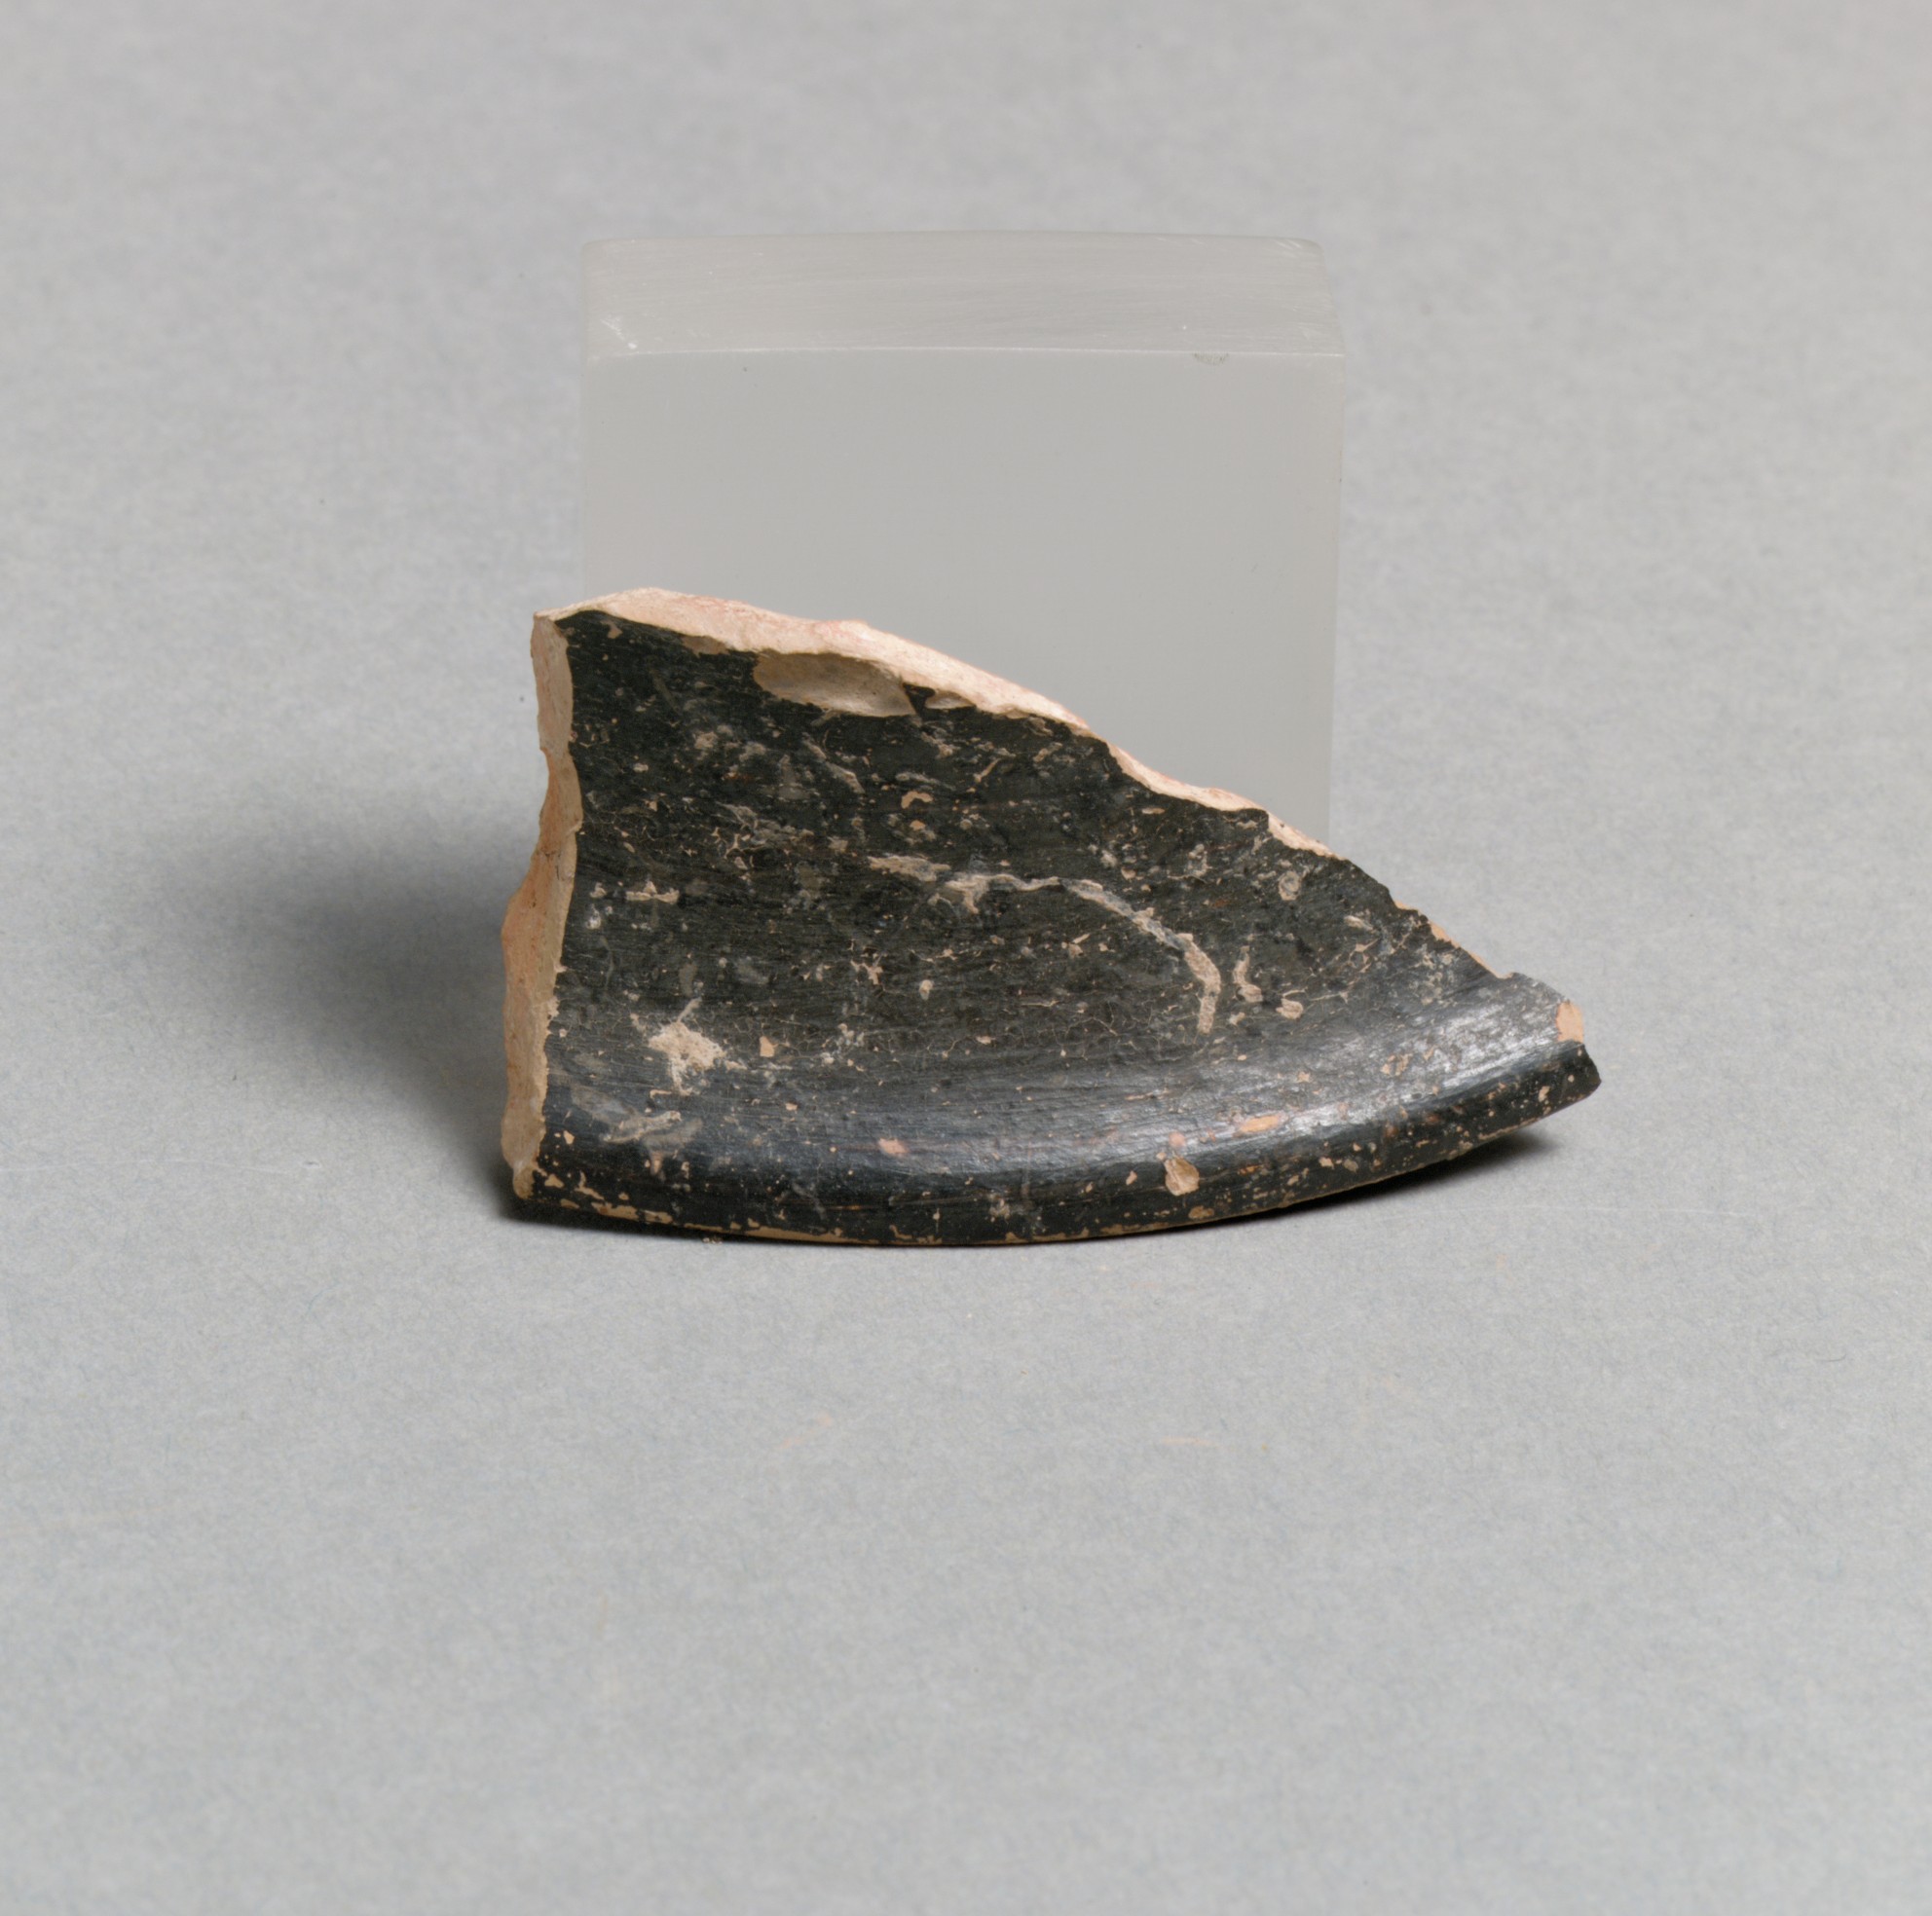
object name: vase fragment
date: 3000-2200 BCE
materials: terracotta